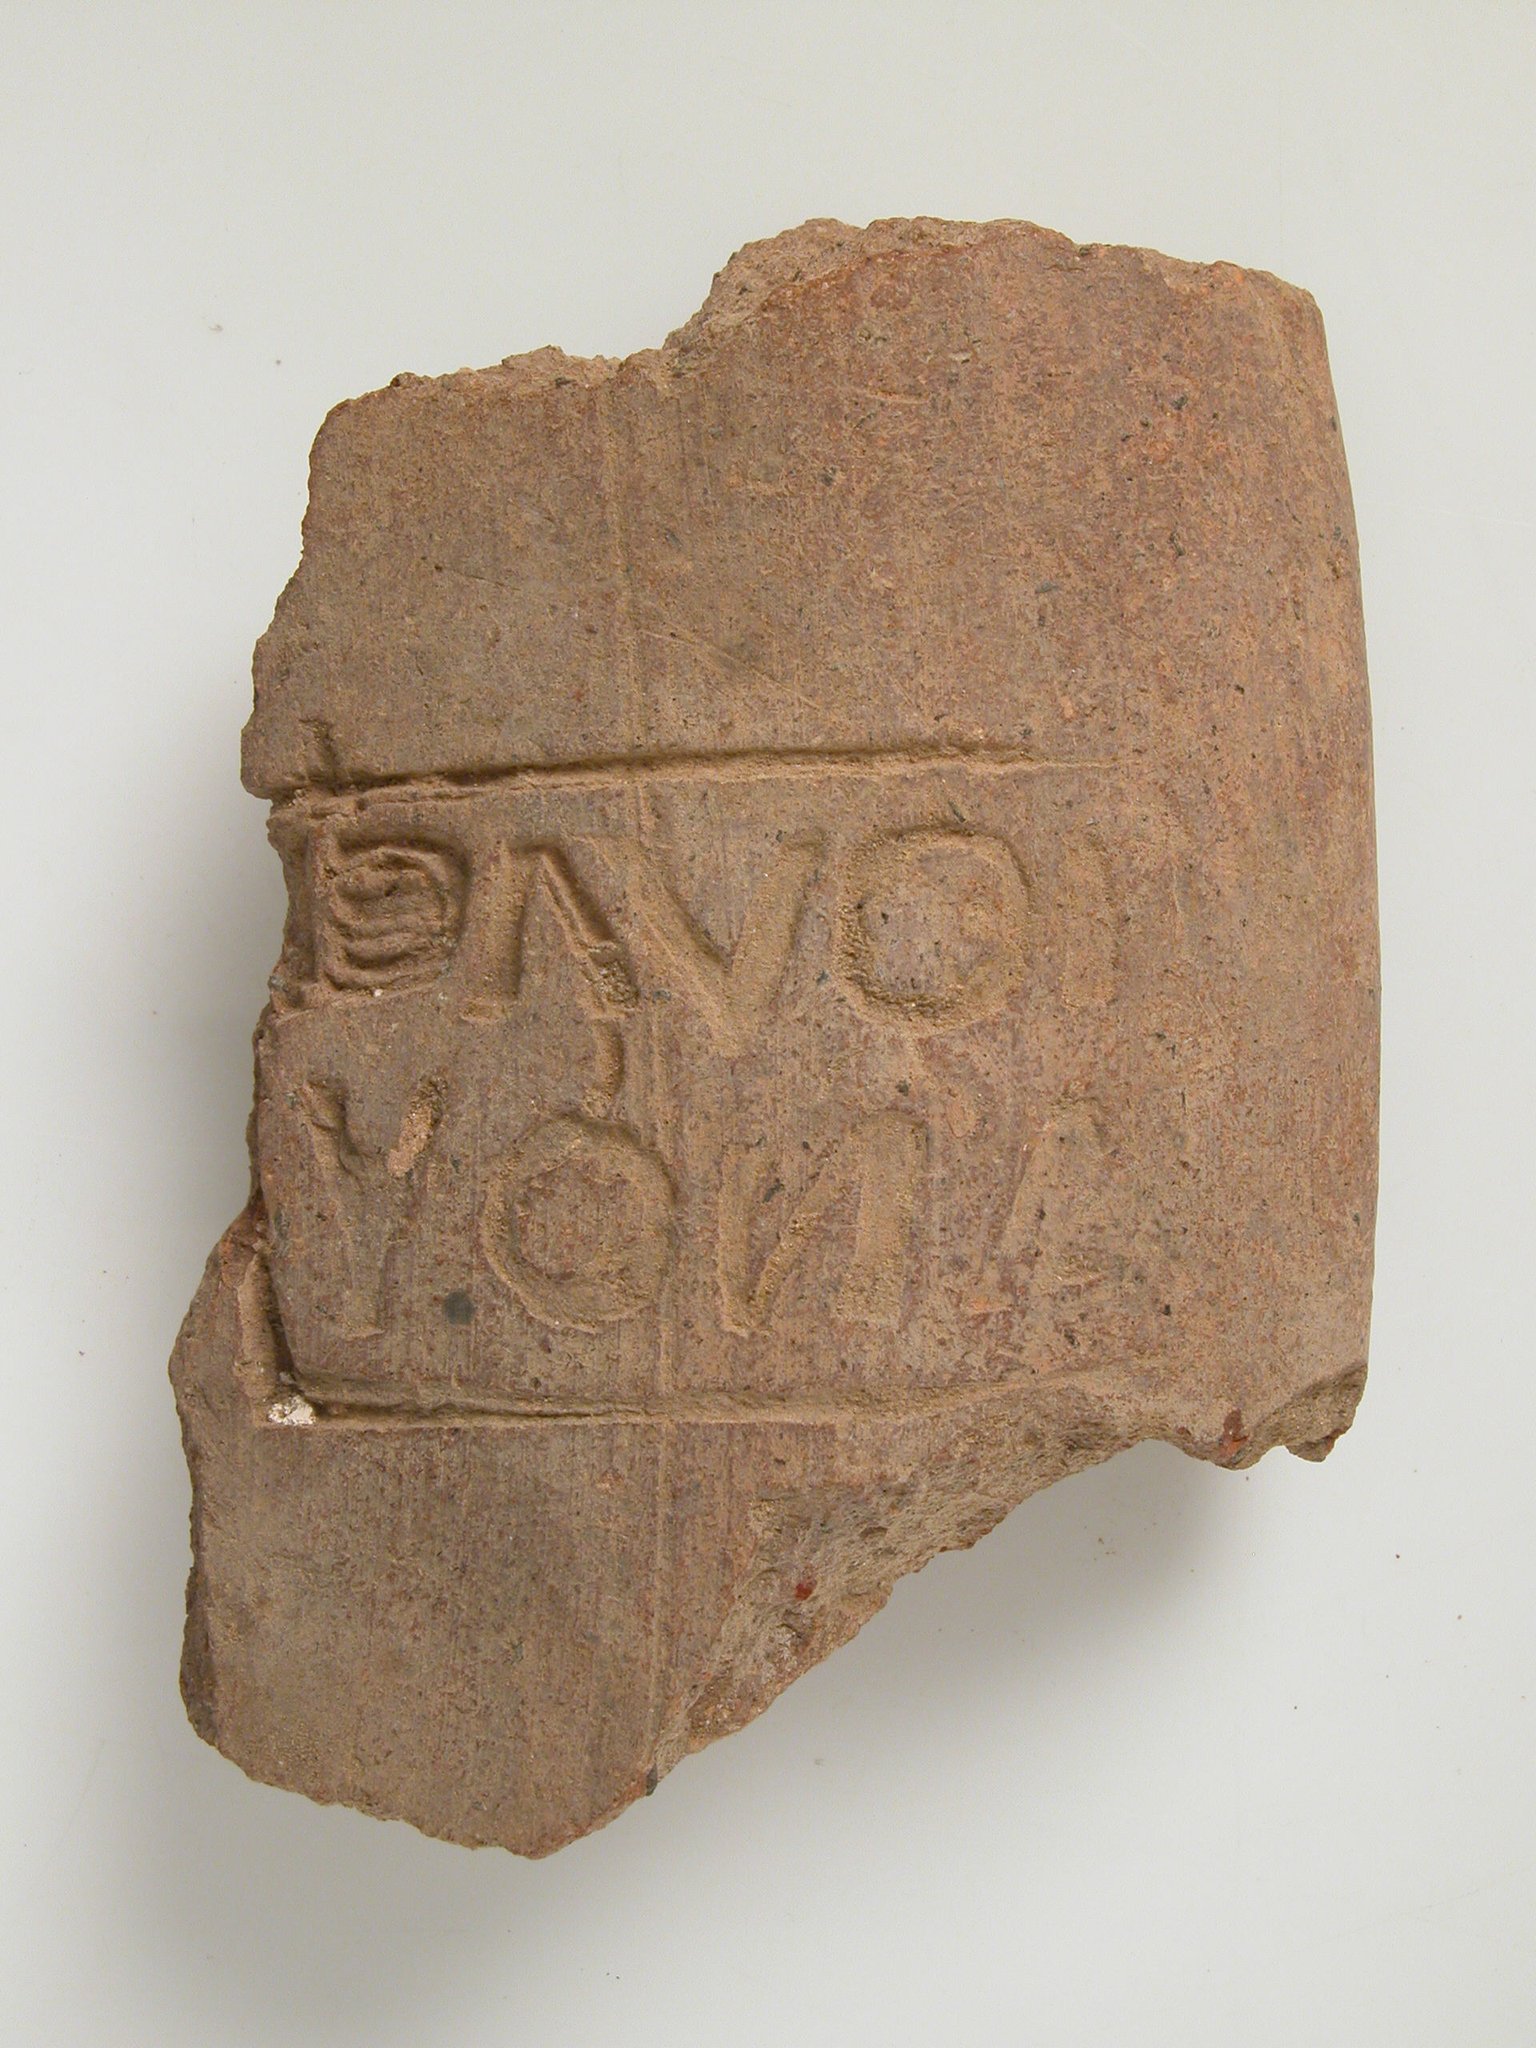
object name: fragment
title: Pottery Fragment with Inscription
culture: coptic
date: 301-700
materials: earthenware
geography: egypt